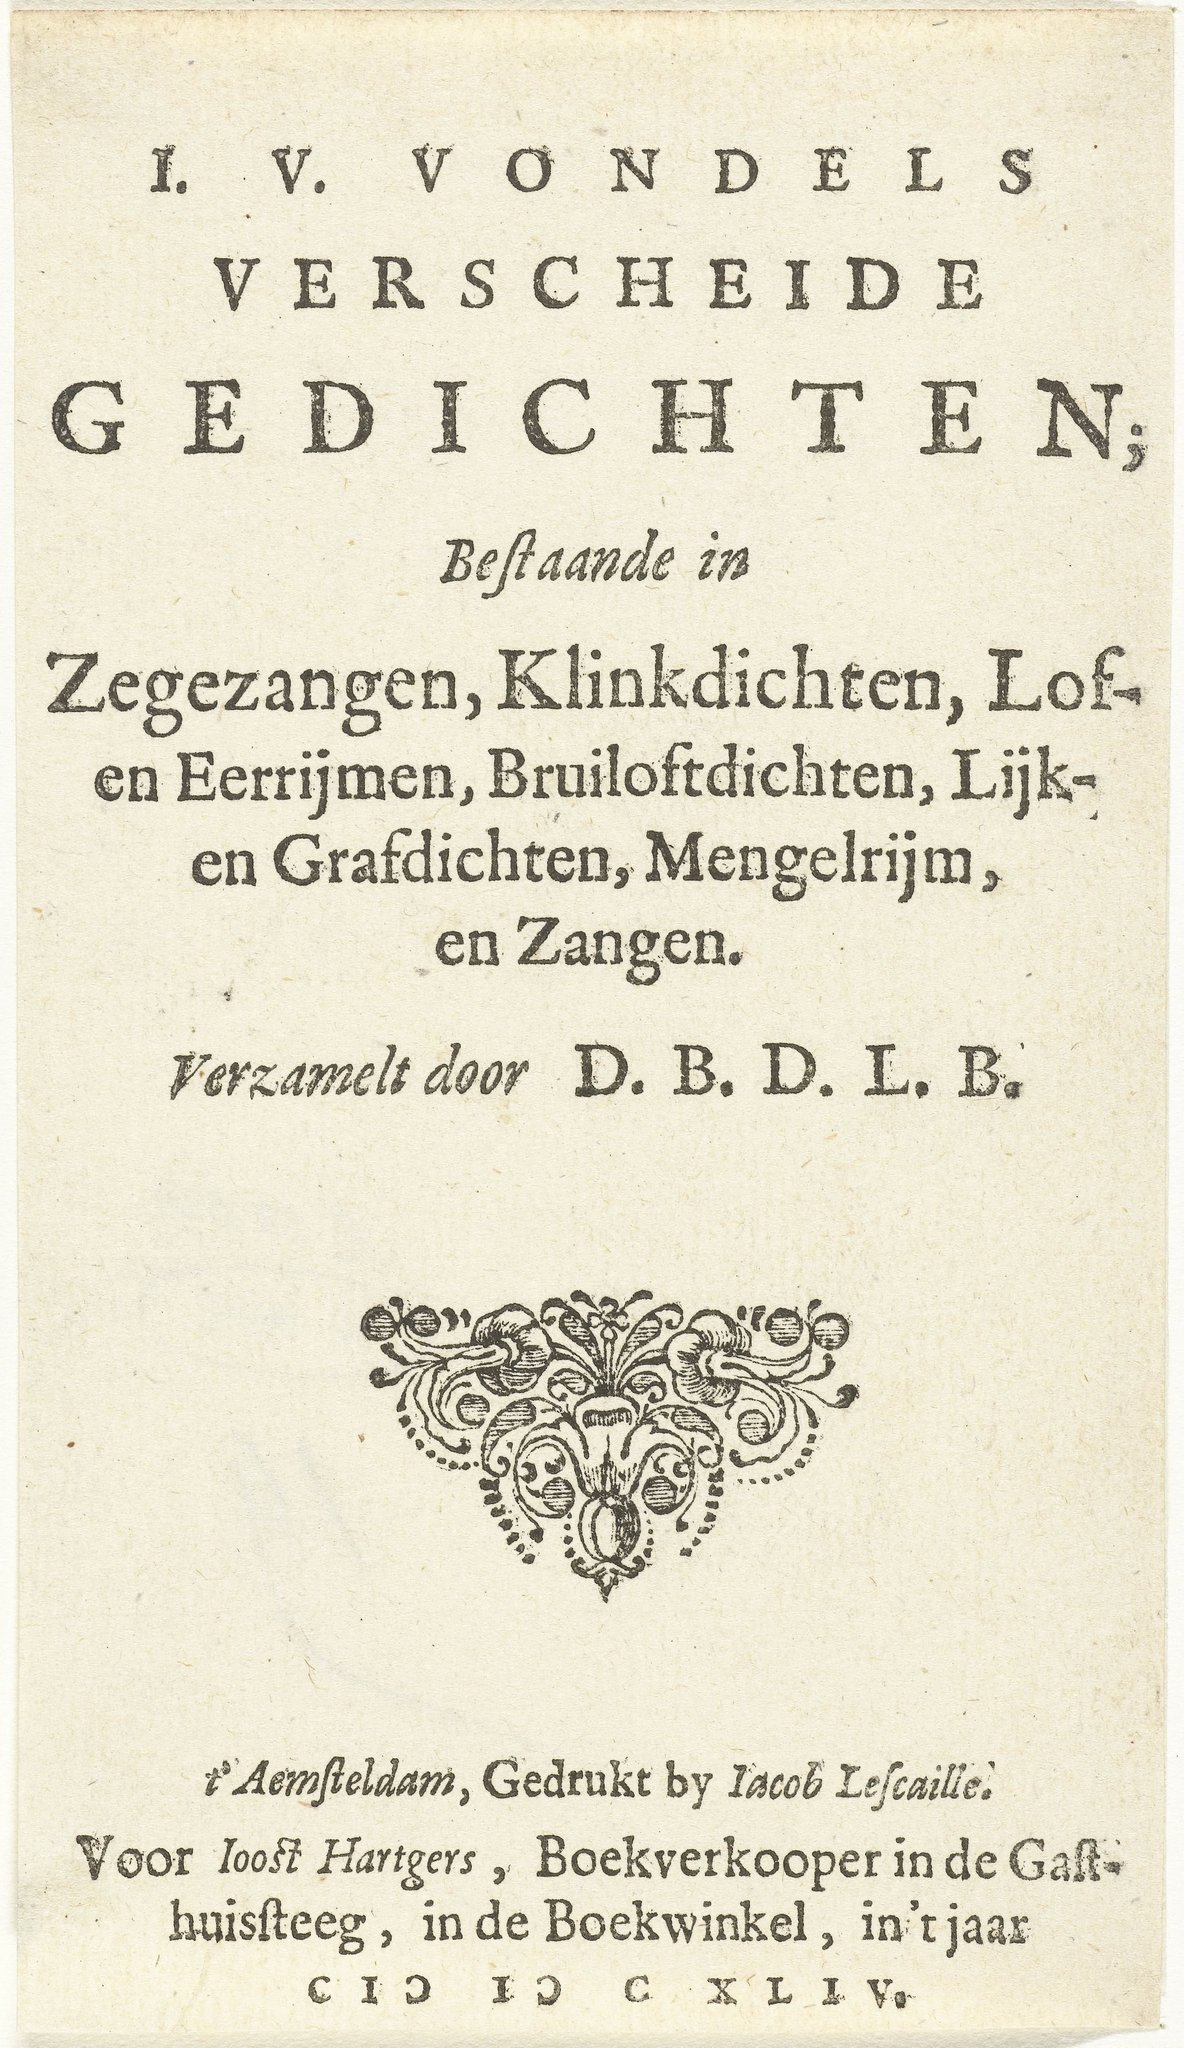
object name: text sheet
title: Titelpagina voor: Joost van Vondel, Verscheide gedichten, Amsterdam 1644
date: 1644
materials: paper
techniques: engraving, letterpress printing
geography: amsterdam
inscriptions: collector's mark: Lugt 2228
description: Titelpagina voor: Joost van Vondel, Verscheide gedichten, Jacob Lescailje (drukker), Joost Hartgers (verkoper), Amsterdam 1644